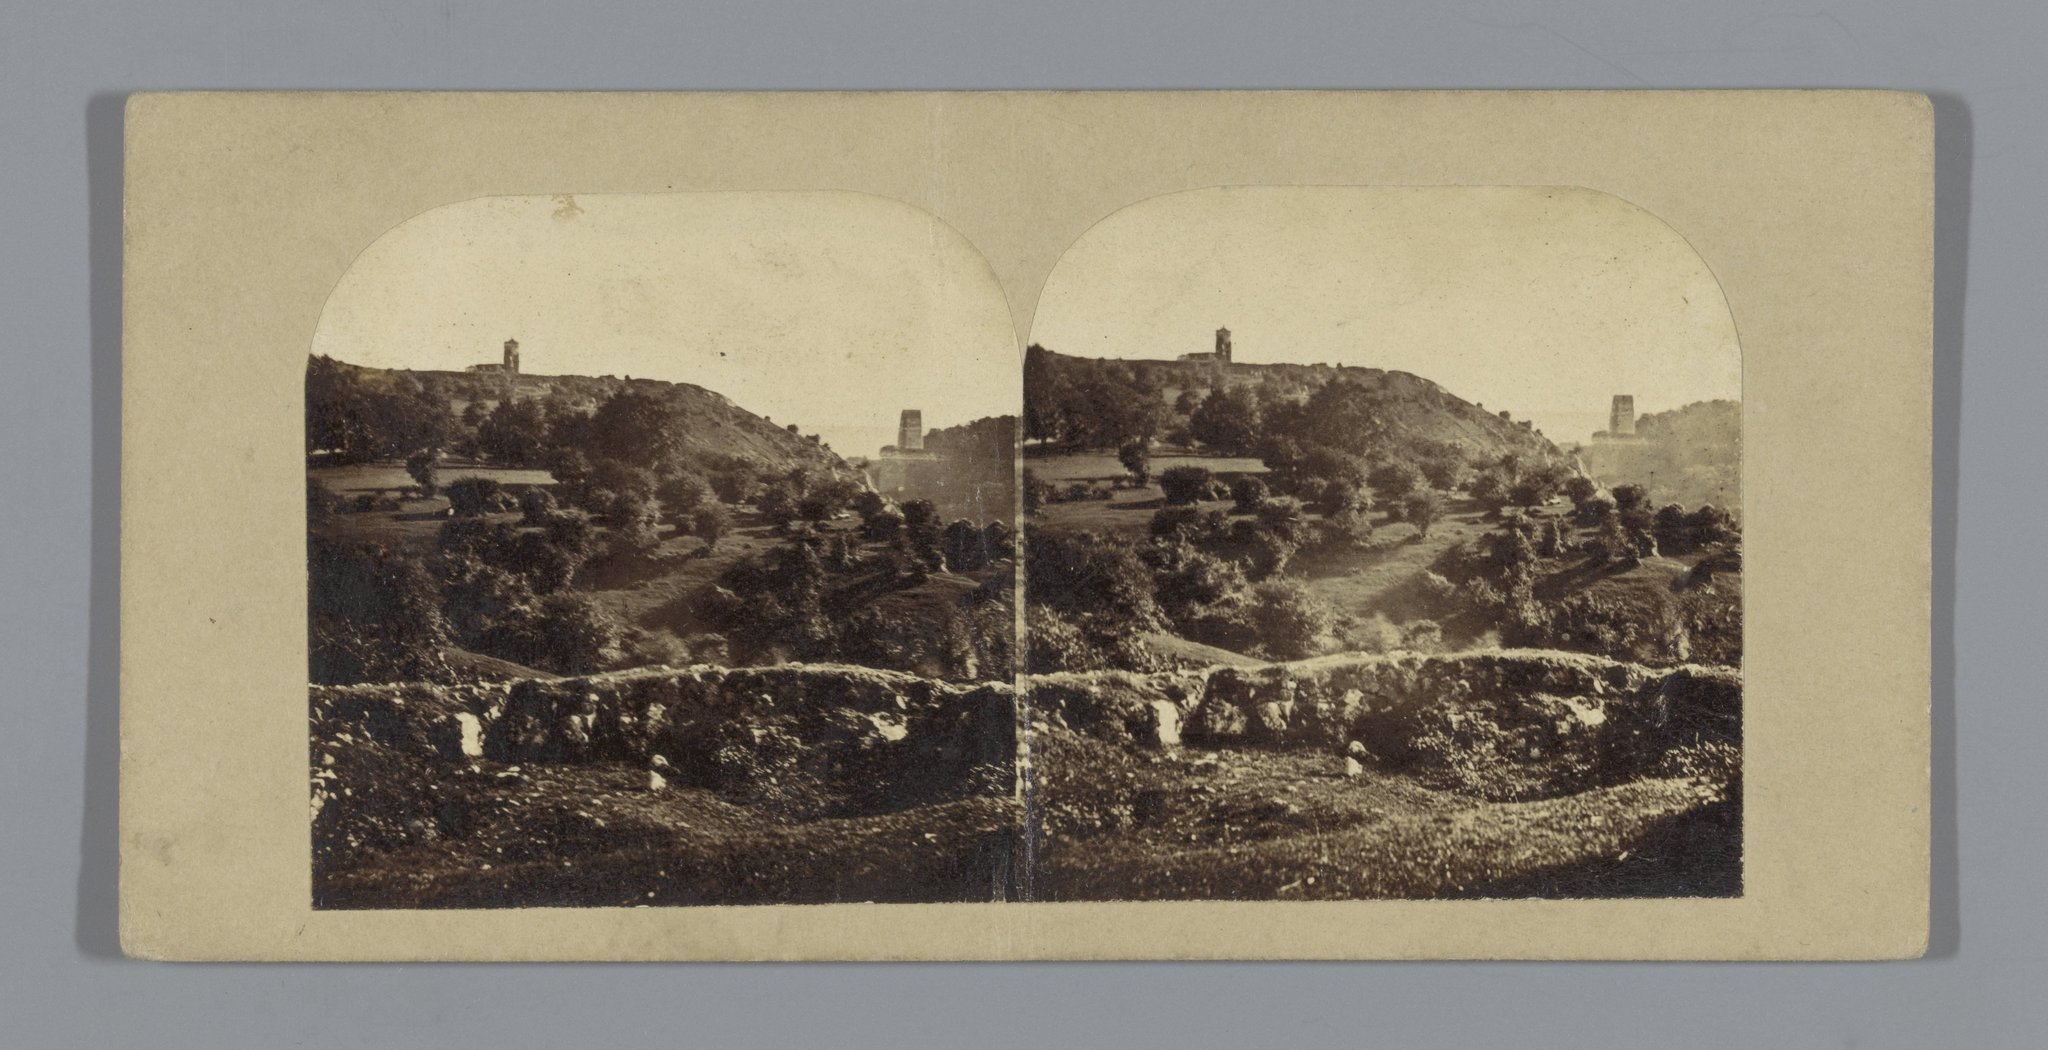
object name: stereograph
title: Gezicht op een heuvel met een kerk, vermoedelijk in Engeland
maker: Anonymous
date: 1850-1880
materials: cardboard, photographic support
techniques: albumen print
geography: england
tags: (high) hill, church (exterior) - qq - small church, chapel, england